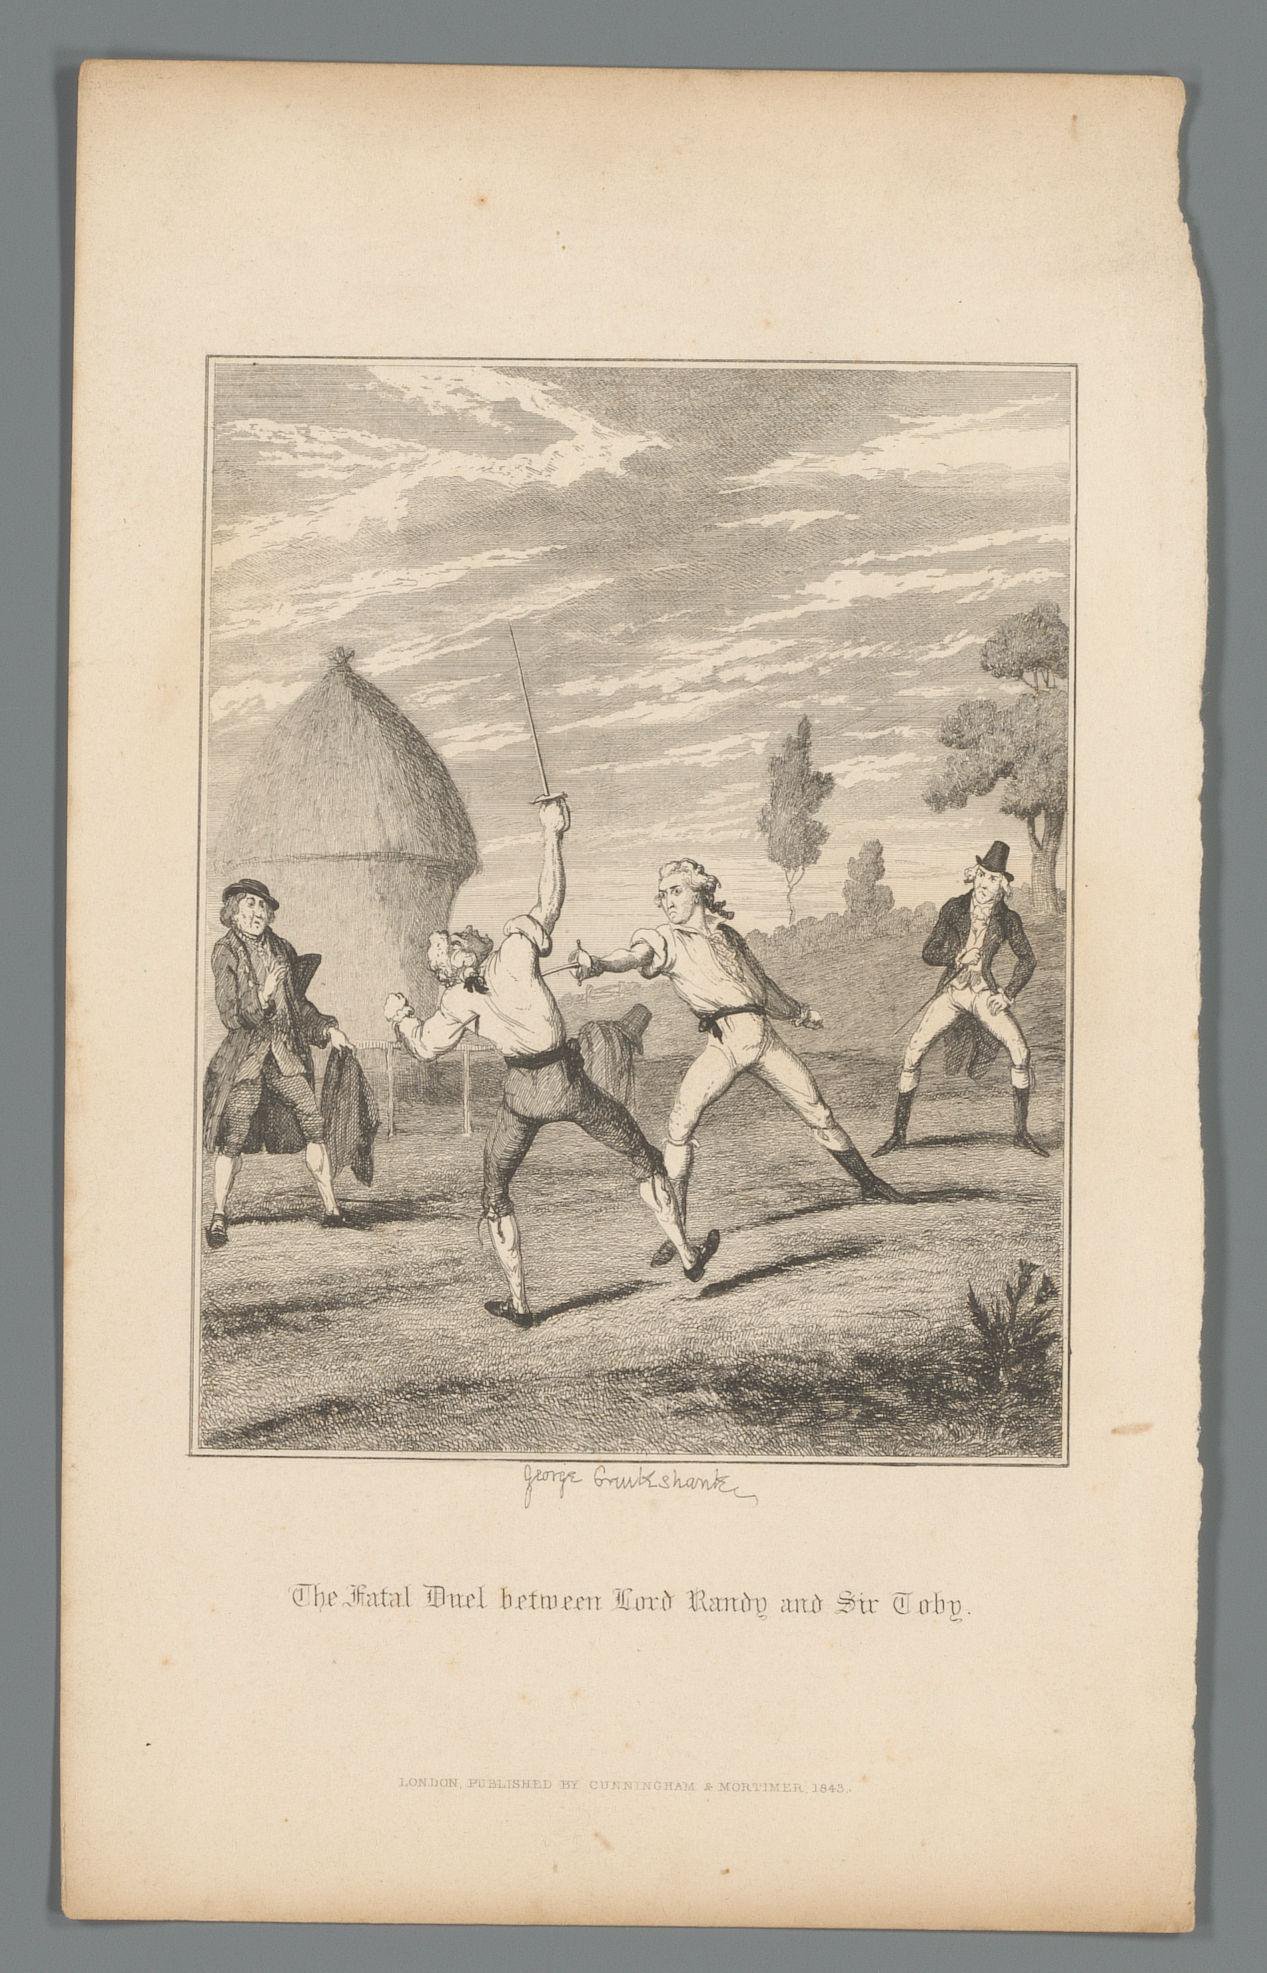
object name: print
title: The Fatal Duel between Lord Randy and Sir Toby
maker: george cruikshank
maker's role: painter, print maker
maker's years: 1792-1878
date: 1843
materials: paper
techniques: etching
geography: england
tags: duelling, political caricatures and satires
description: Het fatale duel tussen Lord Randy en Sir Toby. Illustratie voor een uitgave van "John Manesty; the Liverpool Merchant" van Maginn, 1843-1844.